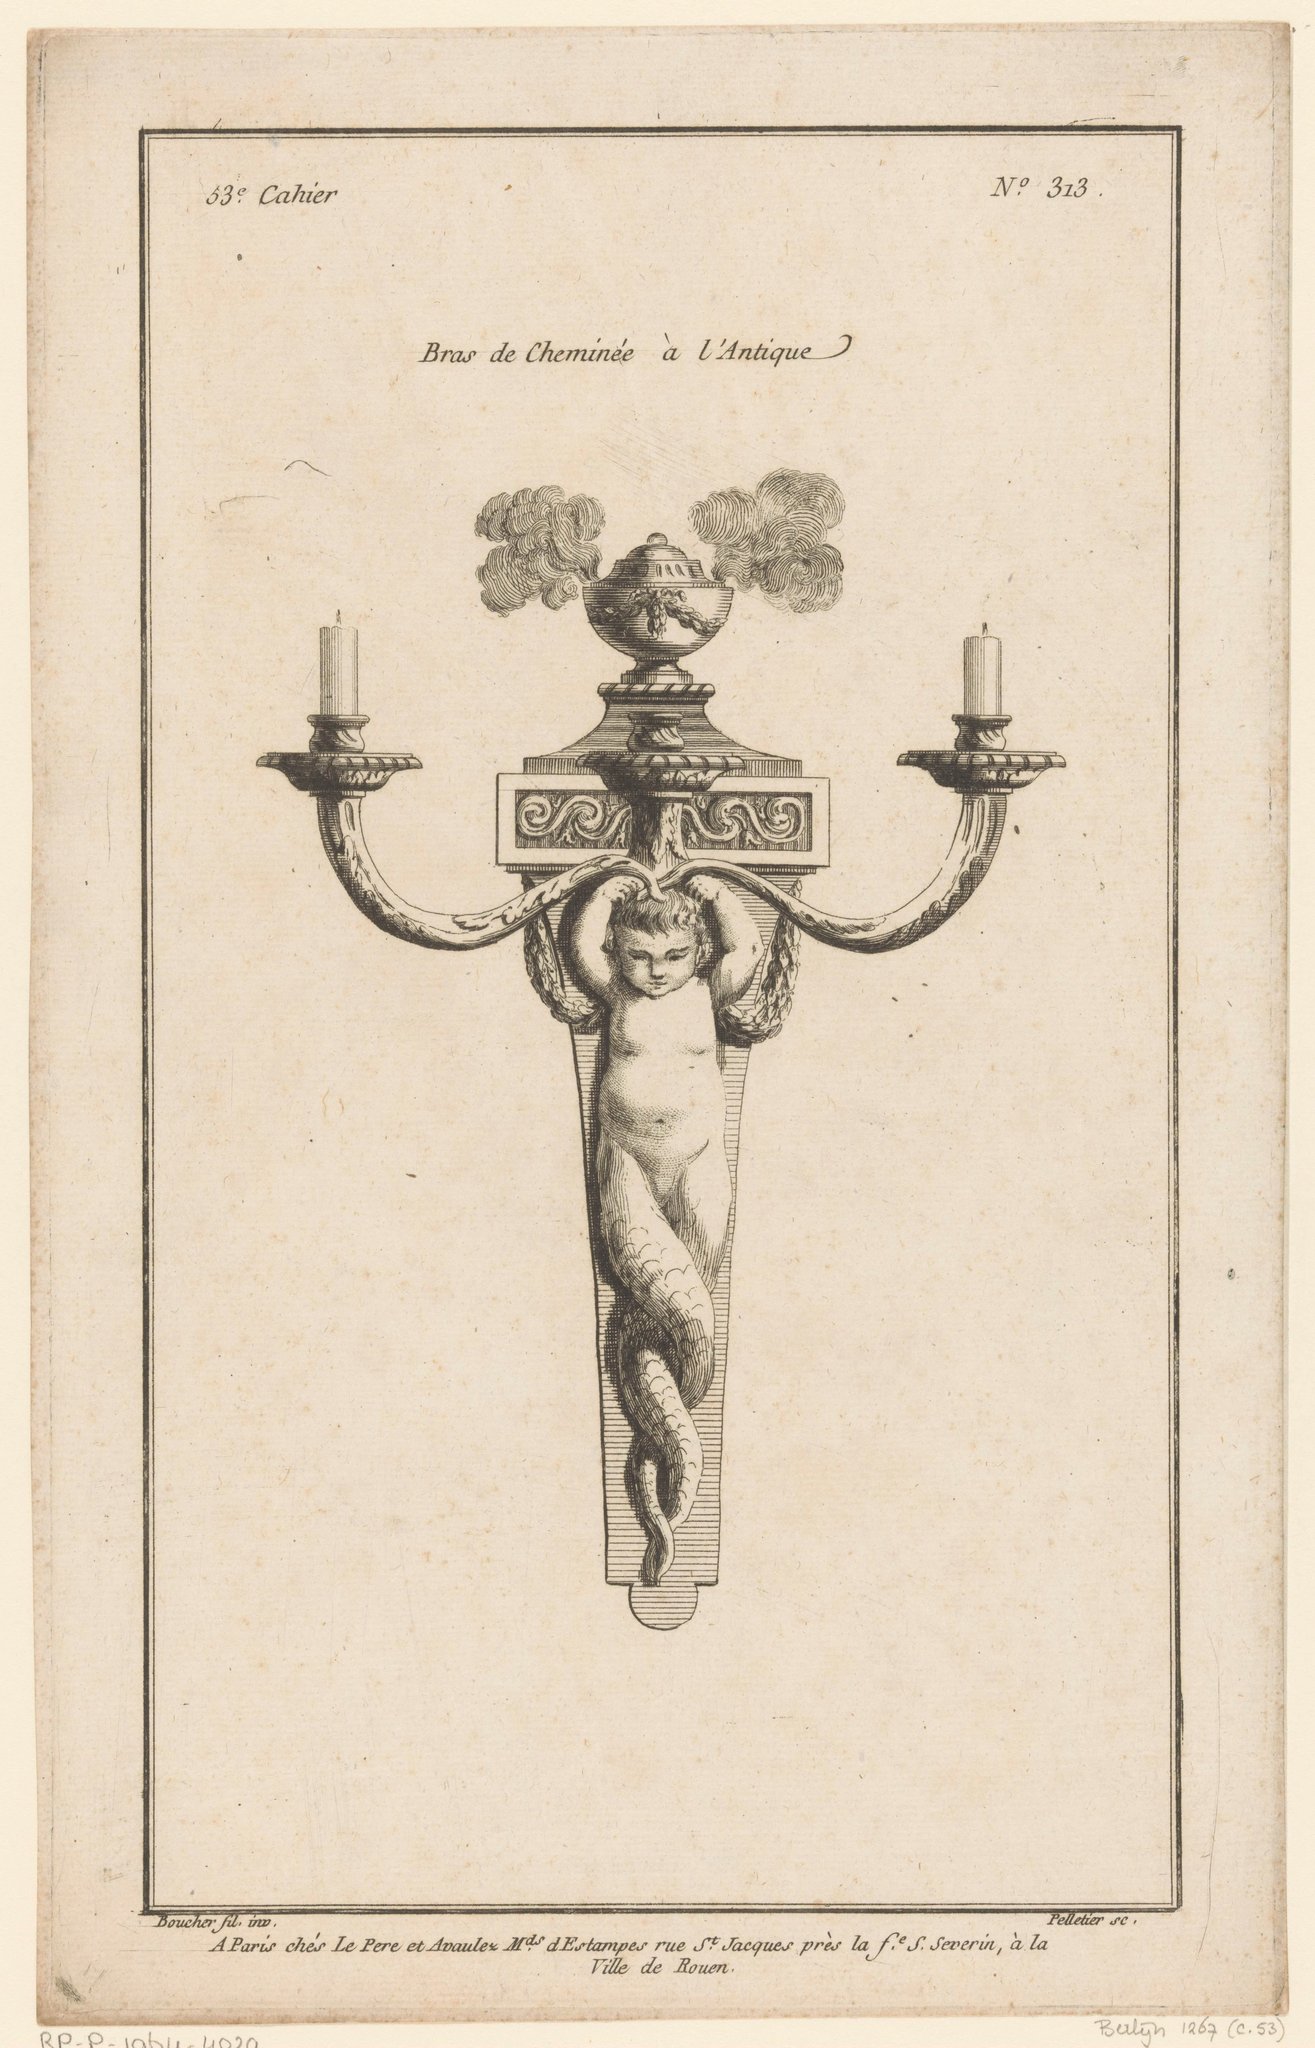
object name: ornament print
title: Bras de Cheminée à l'Antique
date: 1772-1779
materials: paper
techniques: engraving, etching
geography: paris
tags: sconce, wall lamp, incense-burner ~ scents, perfumes, cupids: 'amores', 'amoretti', 'putti'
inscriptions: collector's mark: Lugt 2760, collector's mark: Lugt 2228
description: Een tweearmige wandkandelaar met een putto, de benen in vlechtwerk eindigend, en een rookvat. Prentnummer 313.